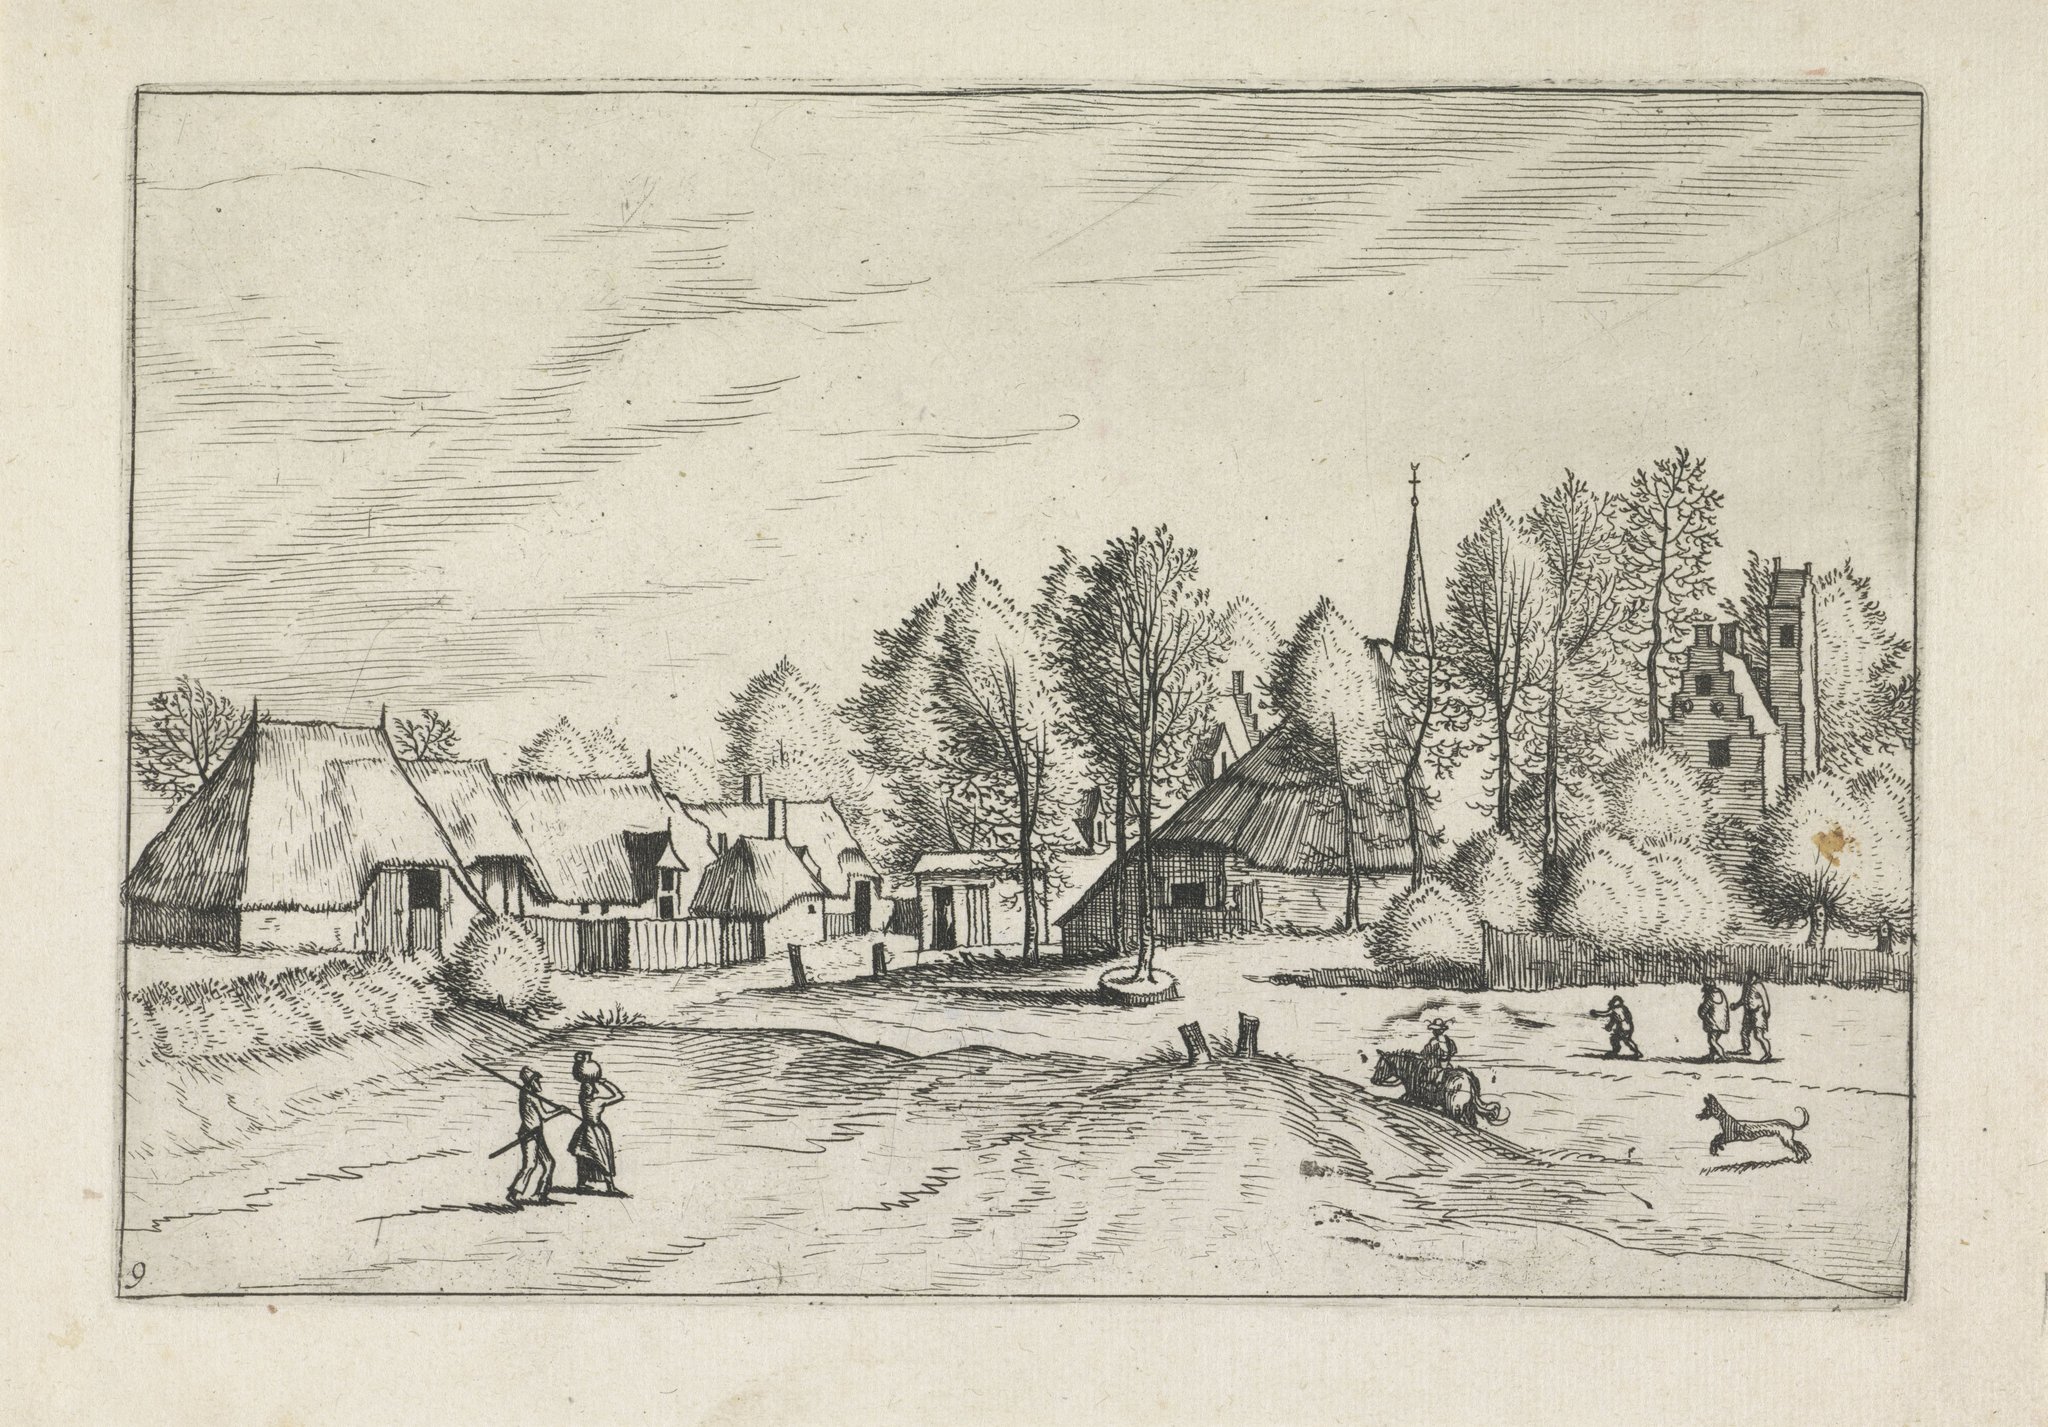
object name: print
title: Kleine landschappen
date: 1559-1561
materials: paper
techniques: etching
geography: antwerp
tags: village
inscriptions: collector's mark: Lugt 2228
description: Dorp met een kerktoren. Op de voorgrond enkele figuren.